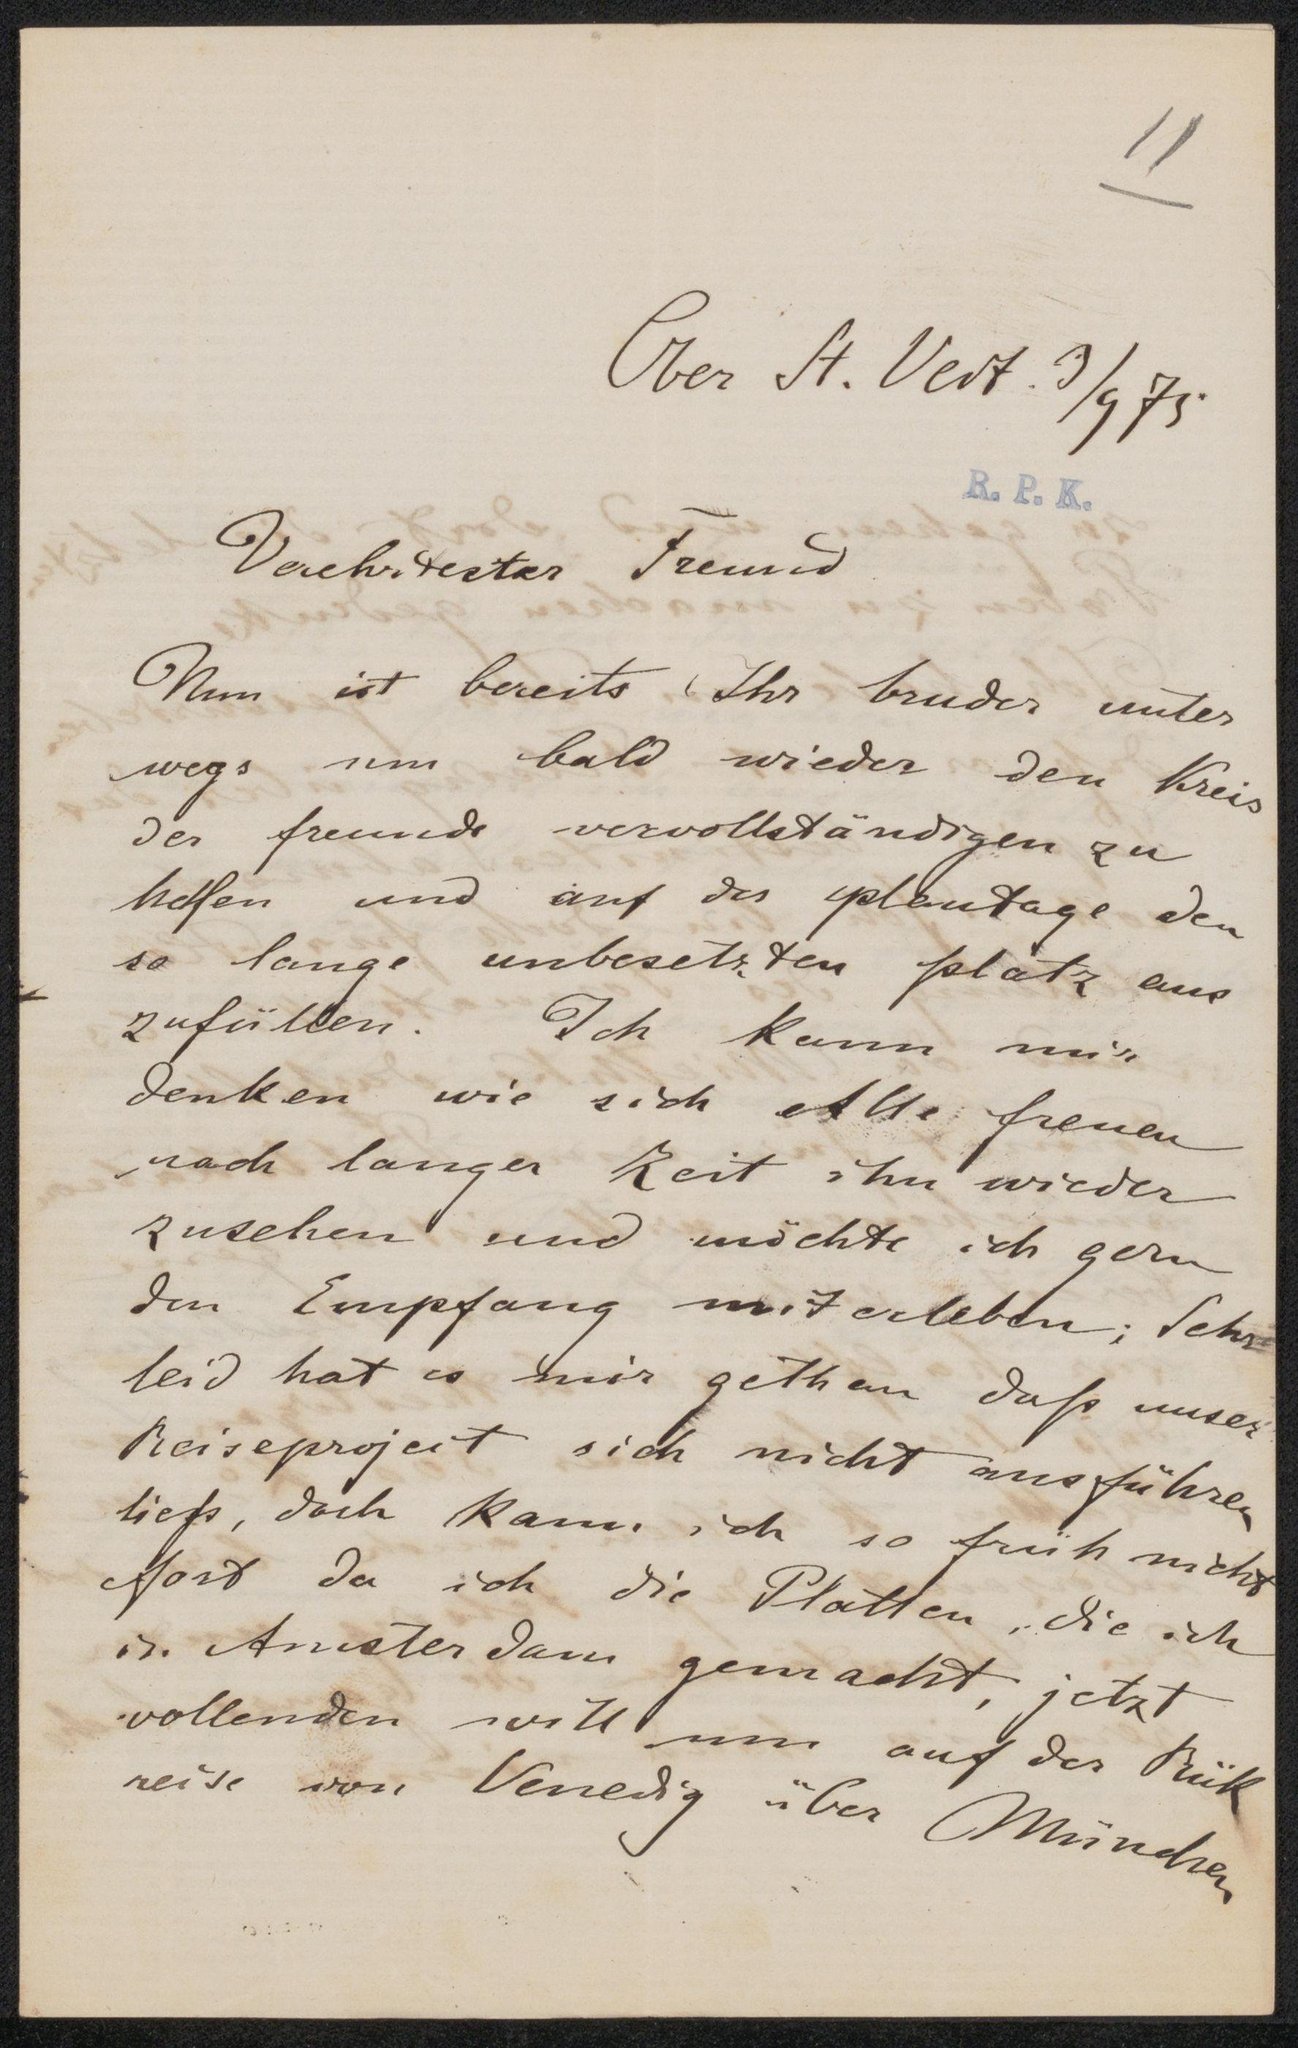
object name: letter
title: Brief aan Frans Buffa en Zonen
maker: william unger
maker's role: draughtsman, painter, print maker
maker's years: 1837-1932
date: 1875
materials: ink, paper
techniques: pen, writing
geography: vienna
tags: georg friedrich felsing, publisher, the graphic arts, travelling; tourism, money, printed matter, venice, amsterdam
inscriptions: collector's mark: Lugt 2233